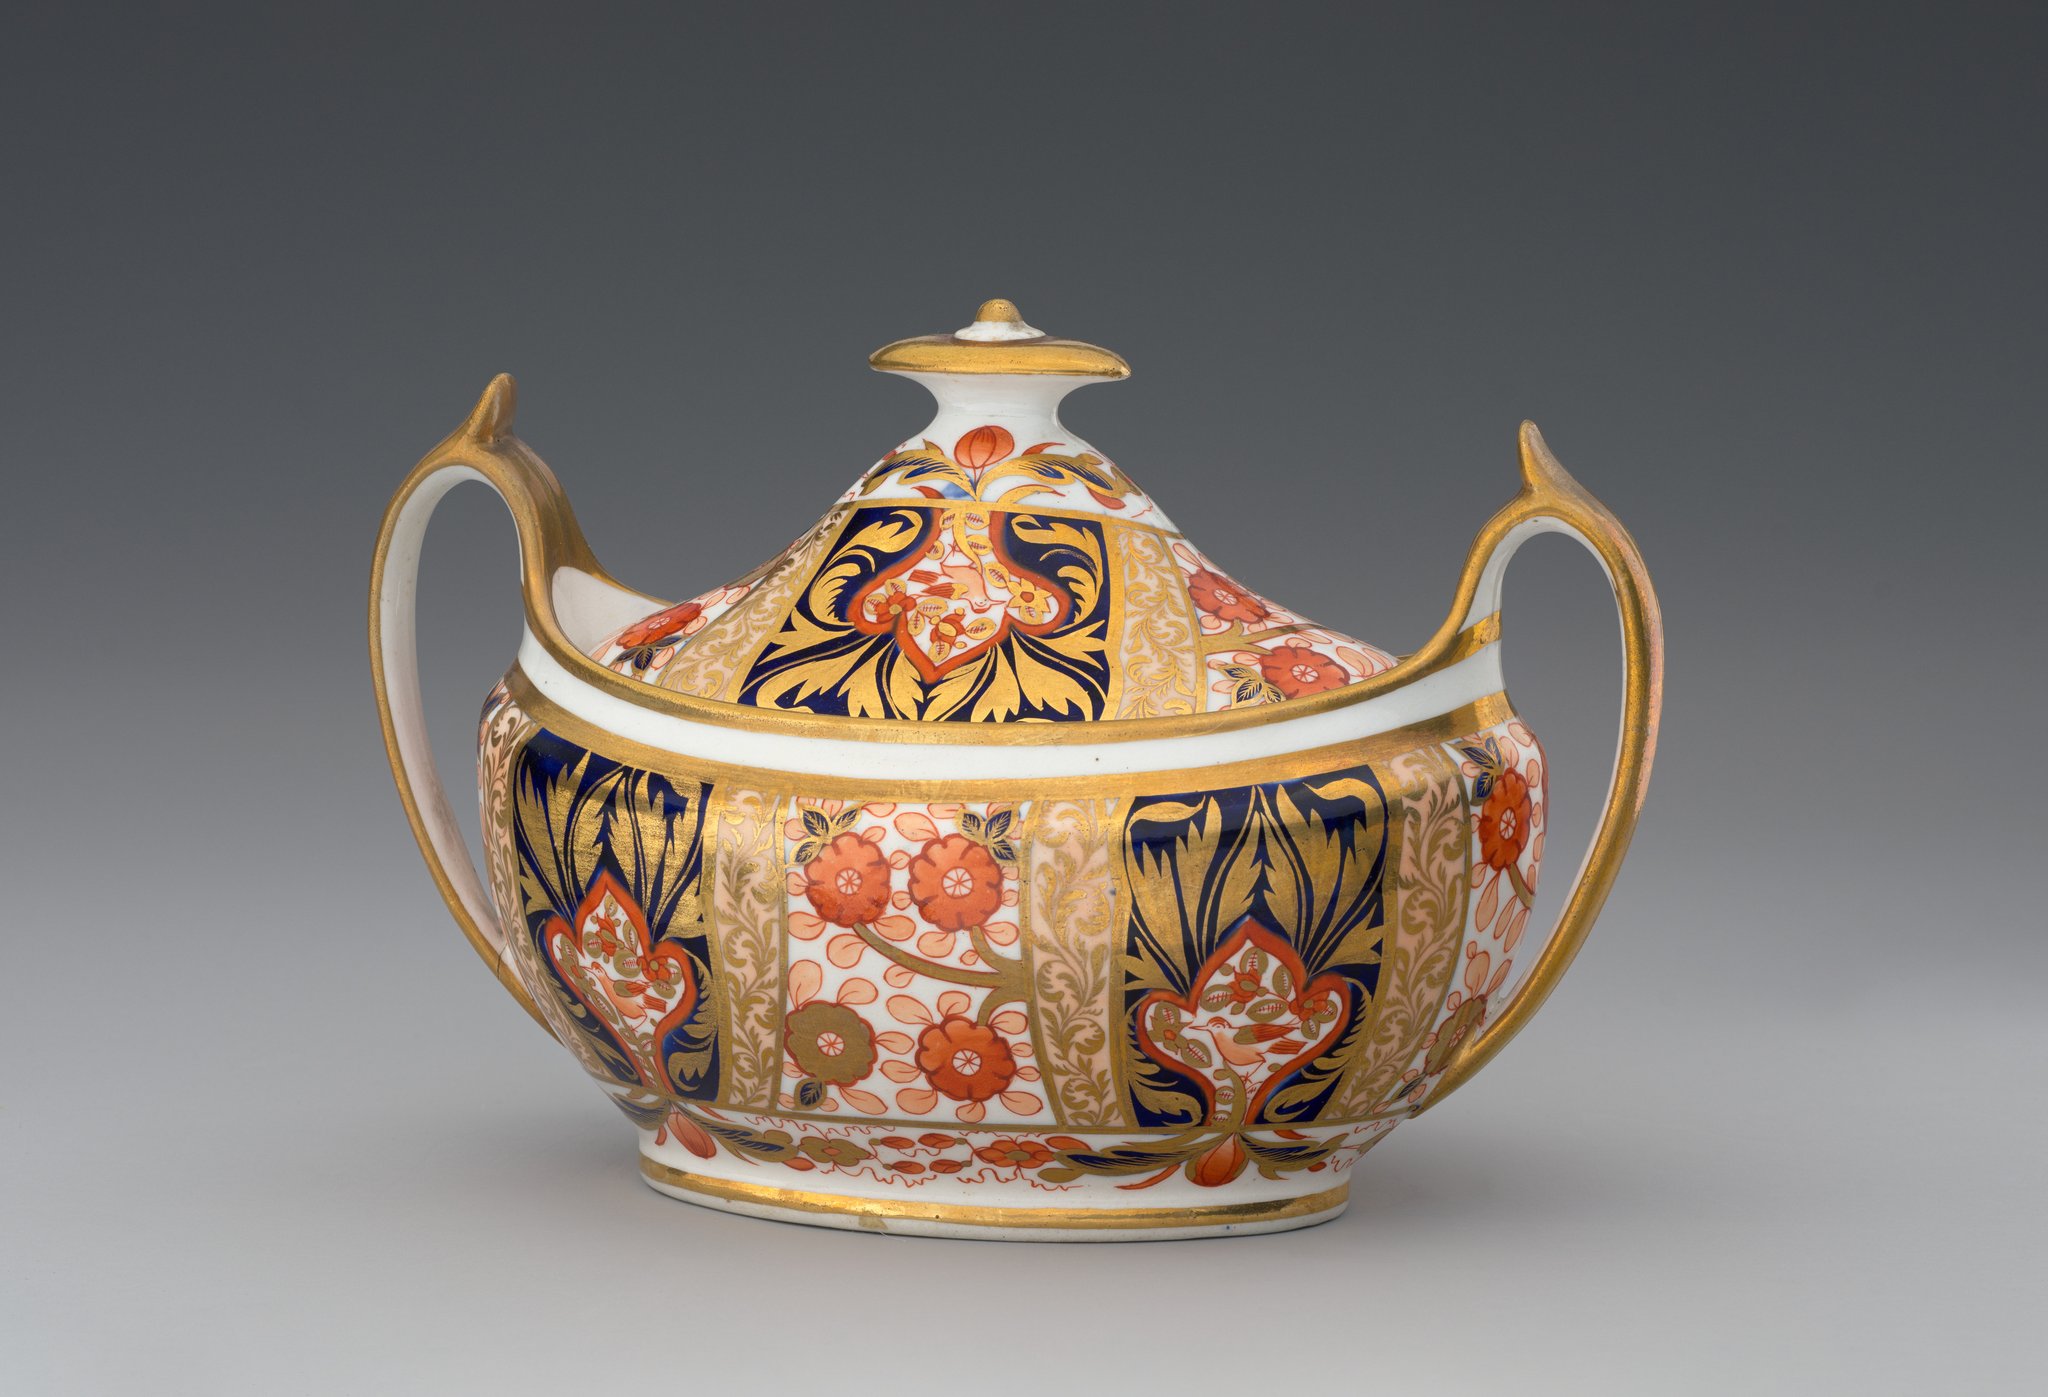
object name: sugar bowl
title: Sugar bowl (part of a service)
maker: j. spode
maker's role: factory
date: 1800-1830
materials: soft paste porcelain